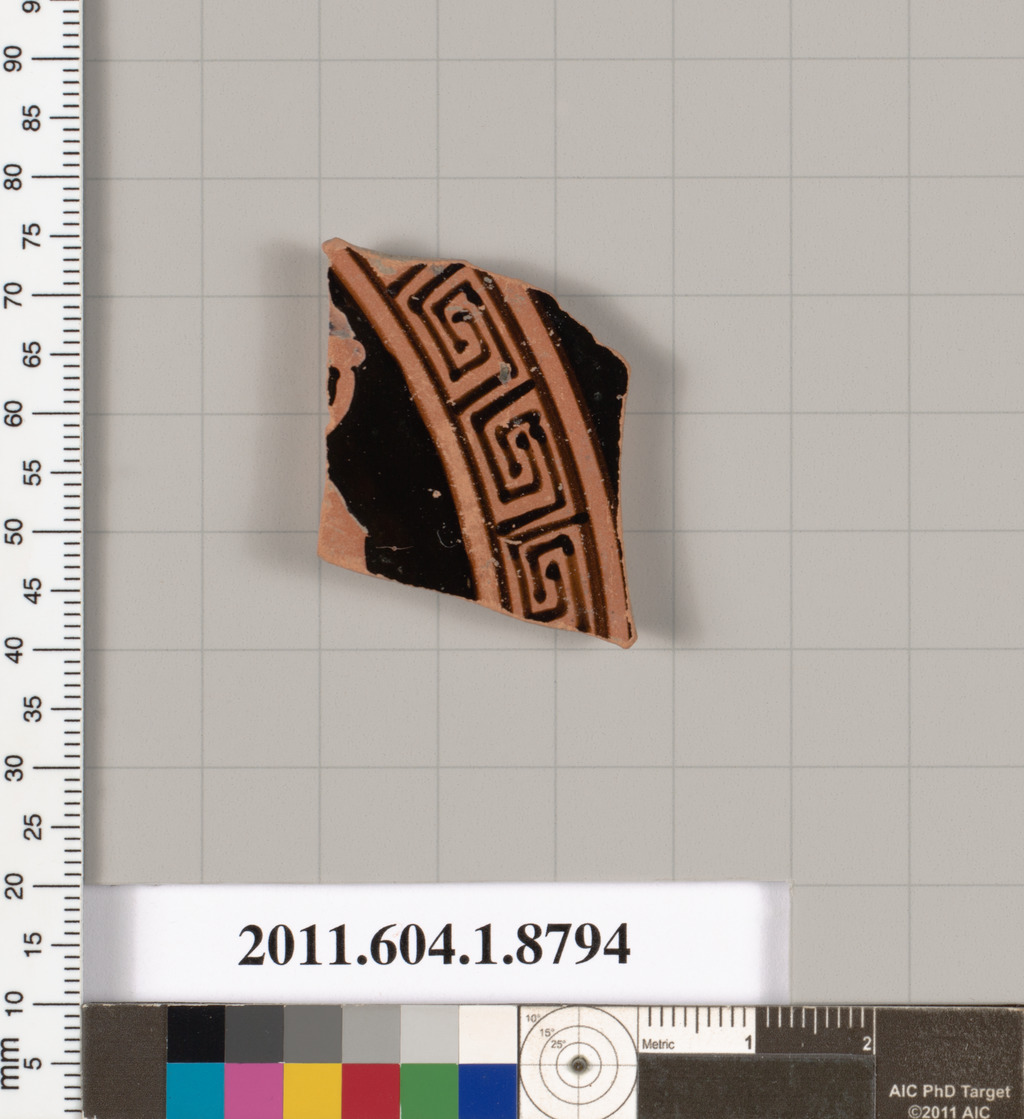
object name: kylix fragment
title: Terracotta fragment of a kylix (drinking cup)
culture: greek, attic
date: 490-480 BCE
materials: terracotta